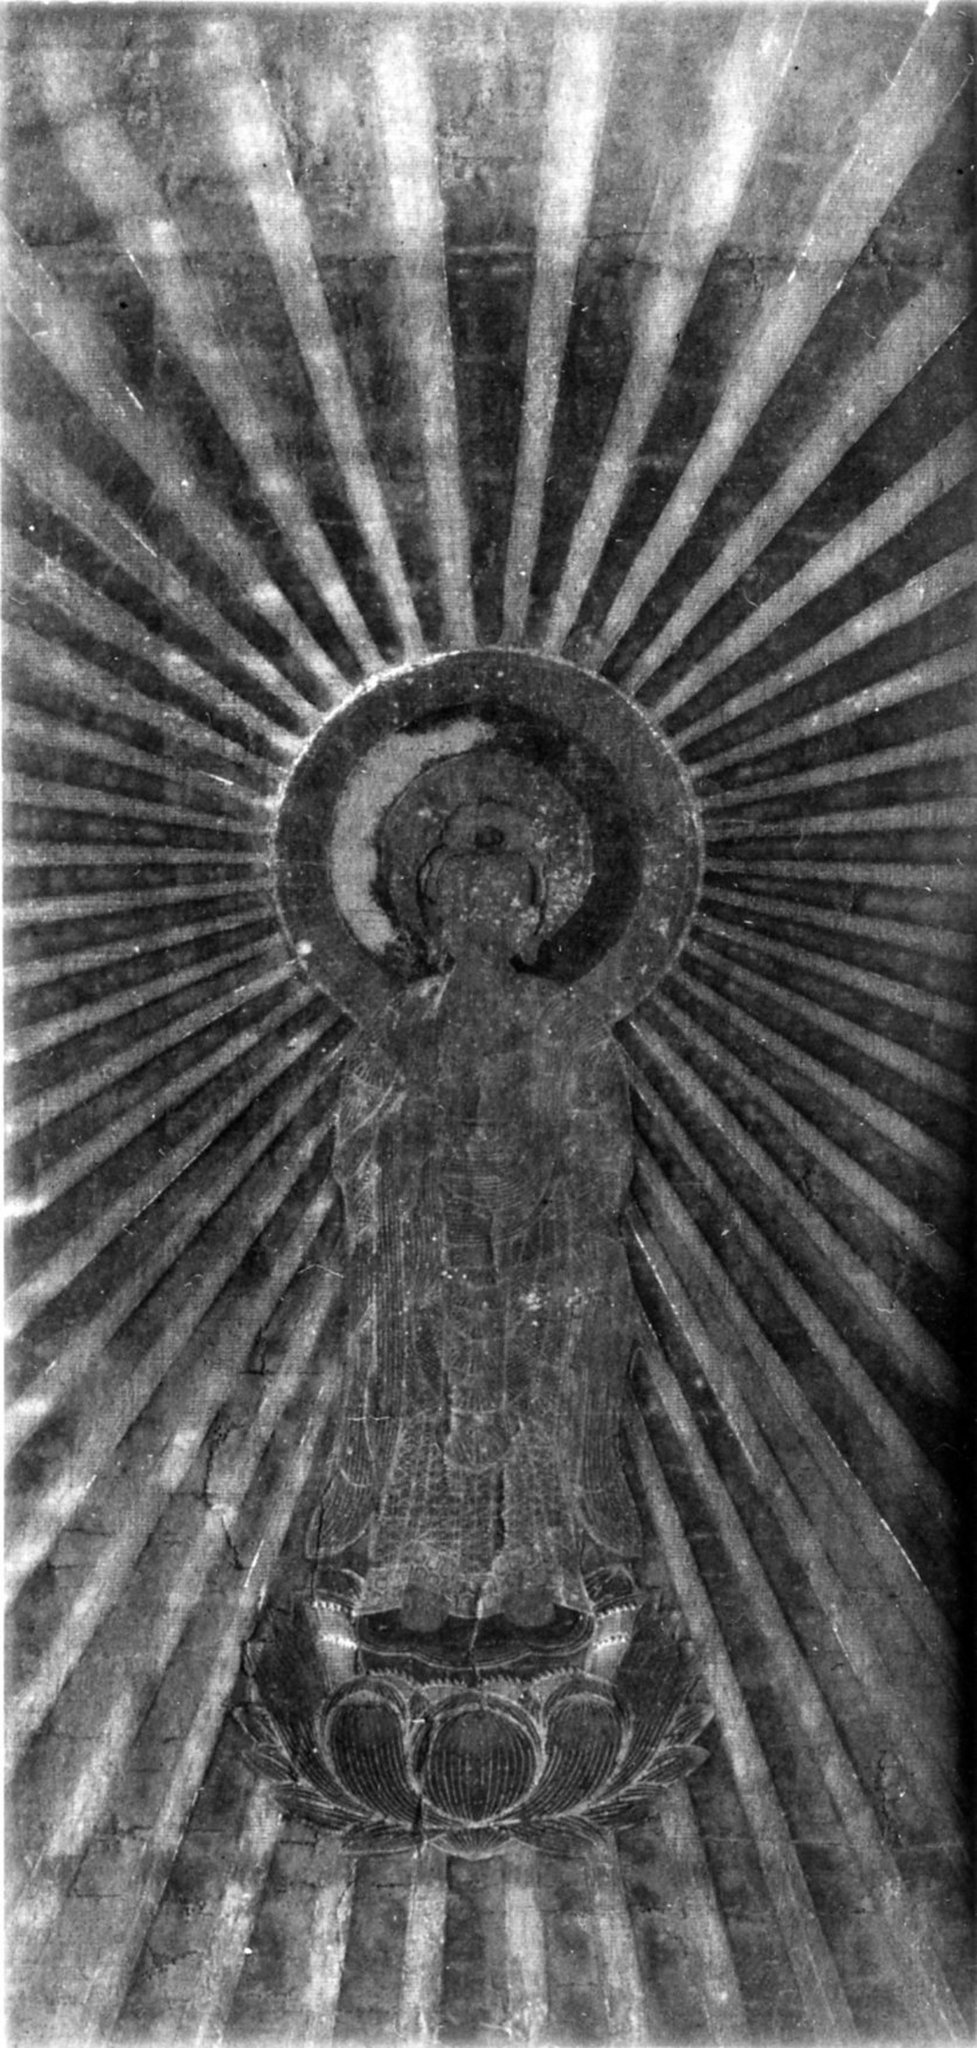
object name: painting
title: Buddha on the Lotus Leaf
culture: japanese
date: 1701-1800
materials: paper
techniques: painting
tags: buddhism,buddha